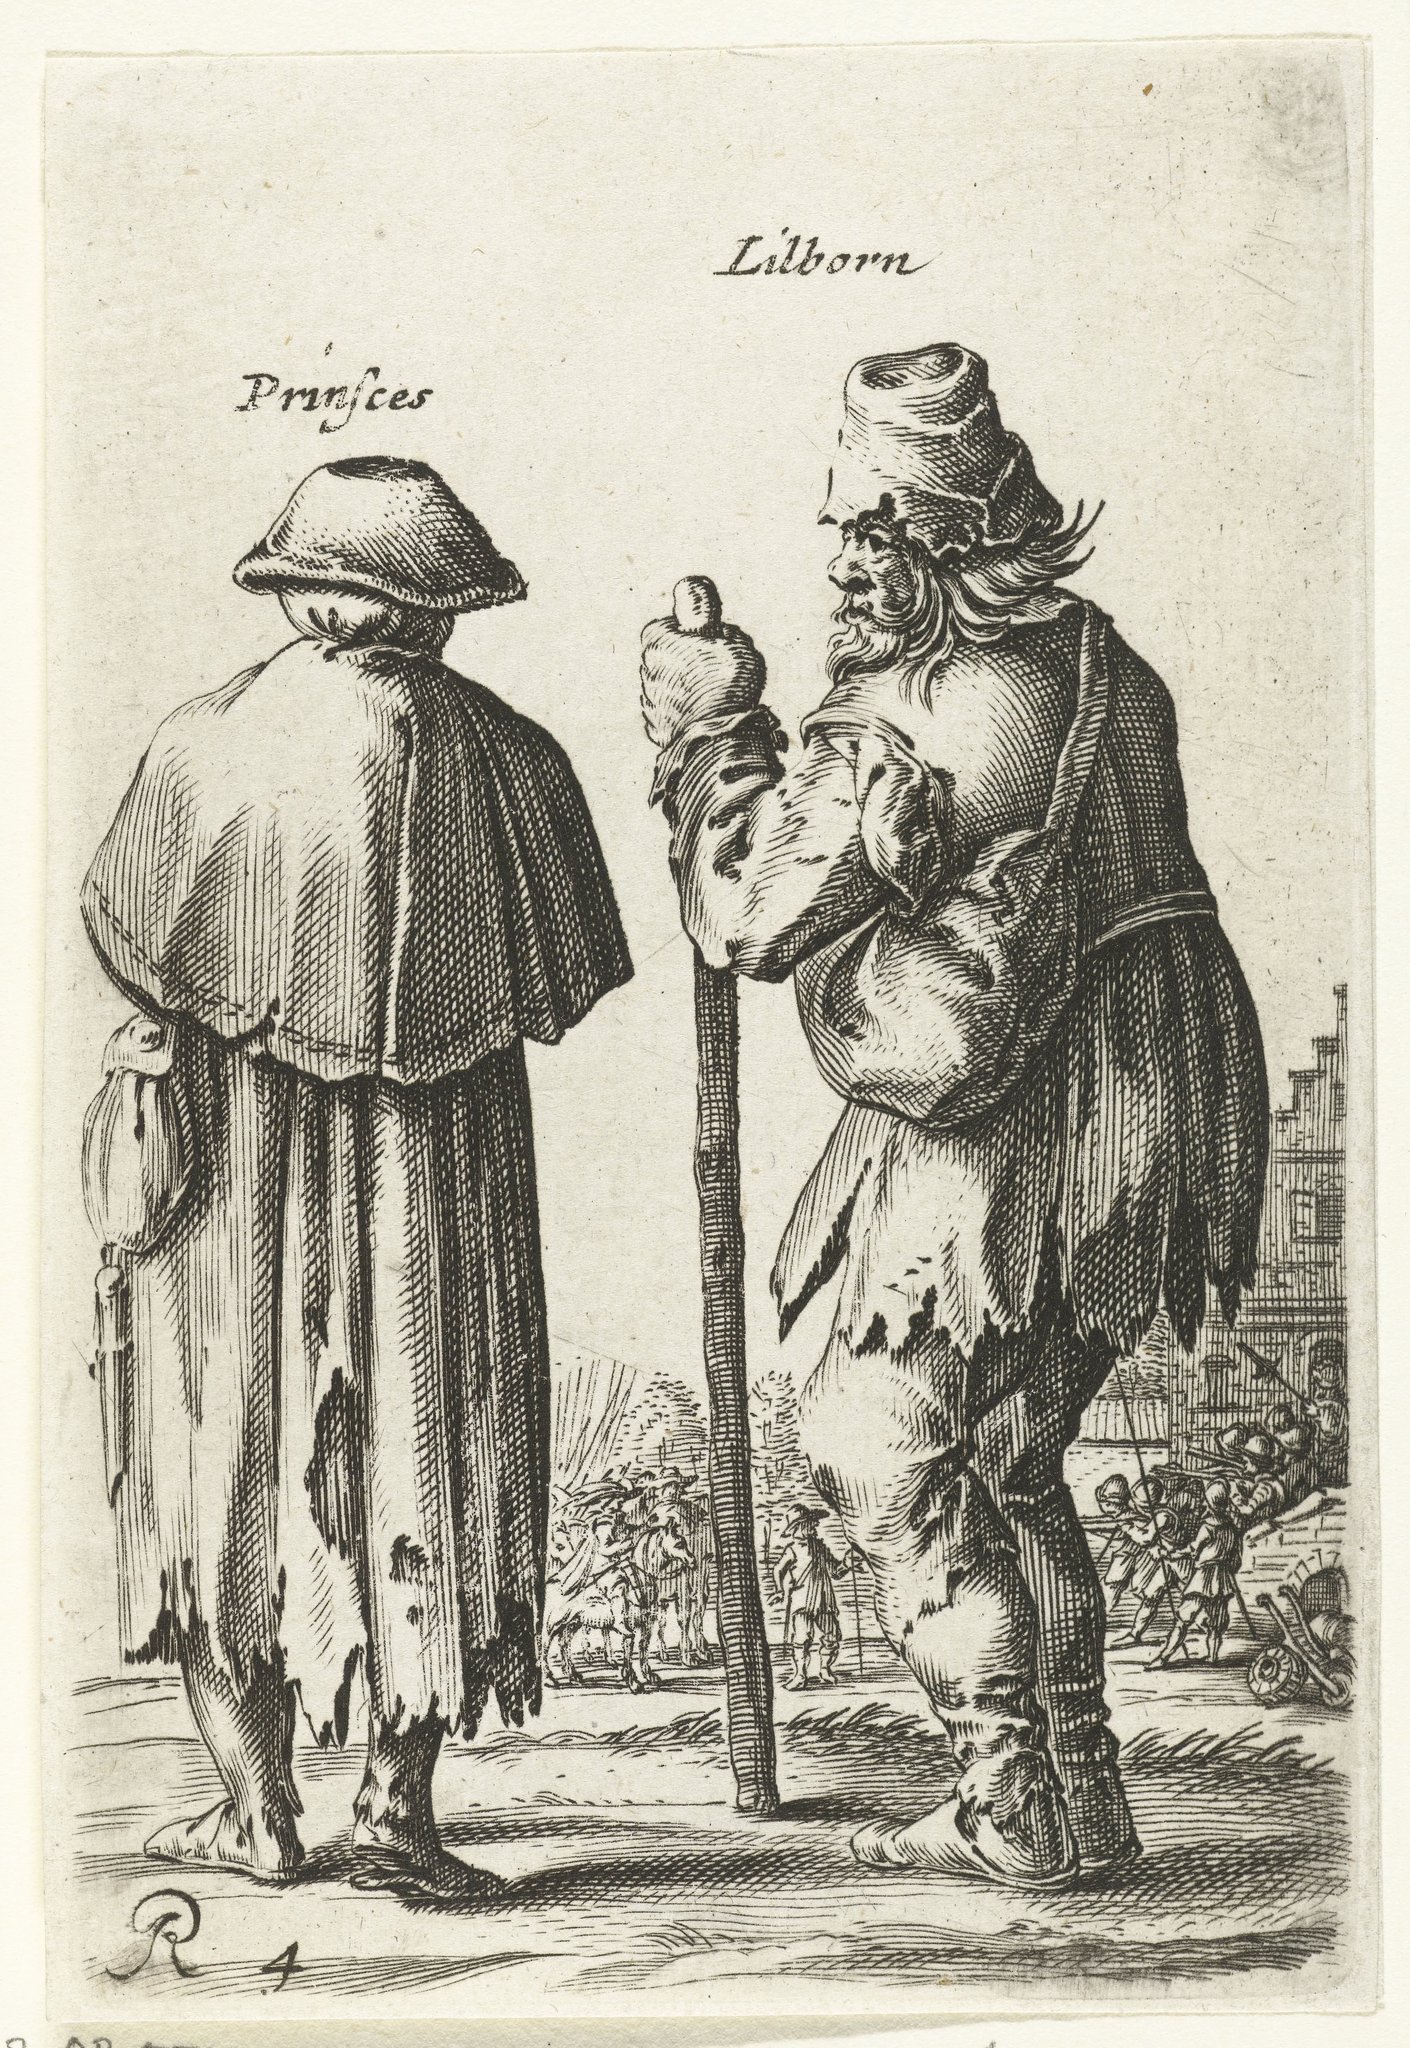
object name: cartoon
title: Bedelaar en bedelares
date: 1638-1665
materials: paper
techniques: engraving, etching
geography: amsterdam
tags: beggar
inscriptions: collector's mark: Lugt 2228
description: Bedelaar en bedelares. Man met stok en vrouw in haveloze kleren, gezien van achteren. Op de achtergrond soldaten en ruiters. De prent maakt deel uit van een tiendelige serie met voorstellingen van bedelaars en boeren waarin ook verschillende ongelukkige figuren uit de Eerste Engelse Oorlog zijn opgenomen, ca. 1652-1654.